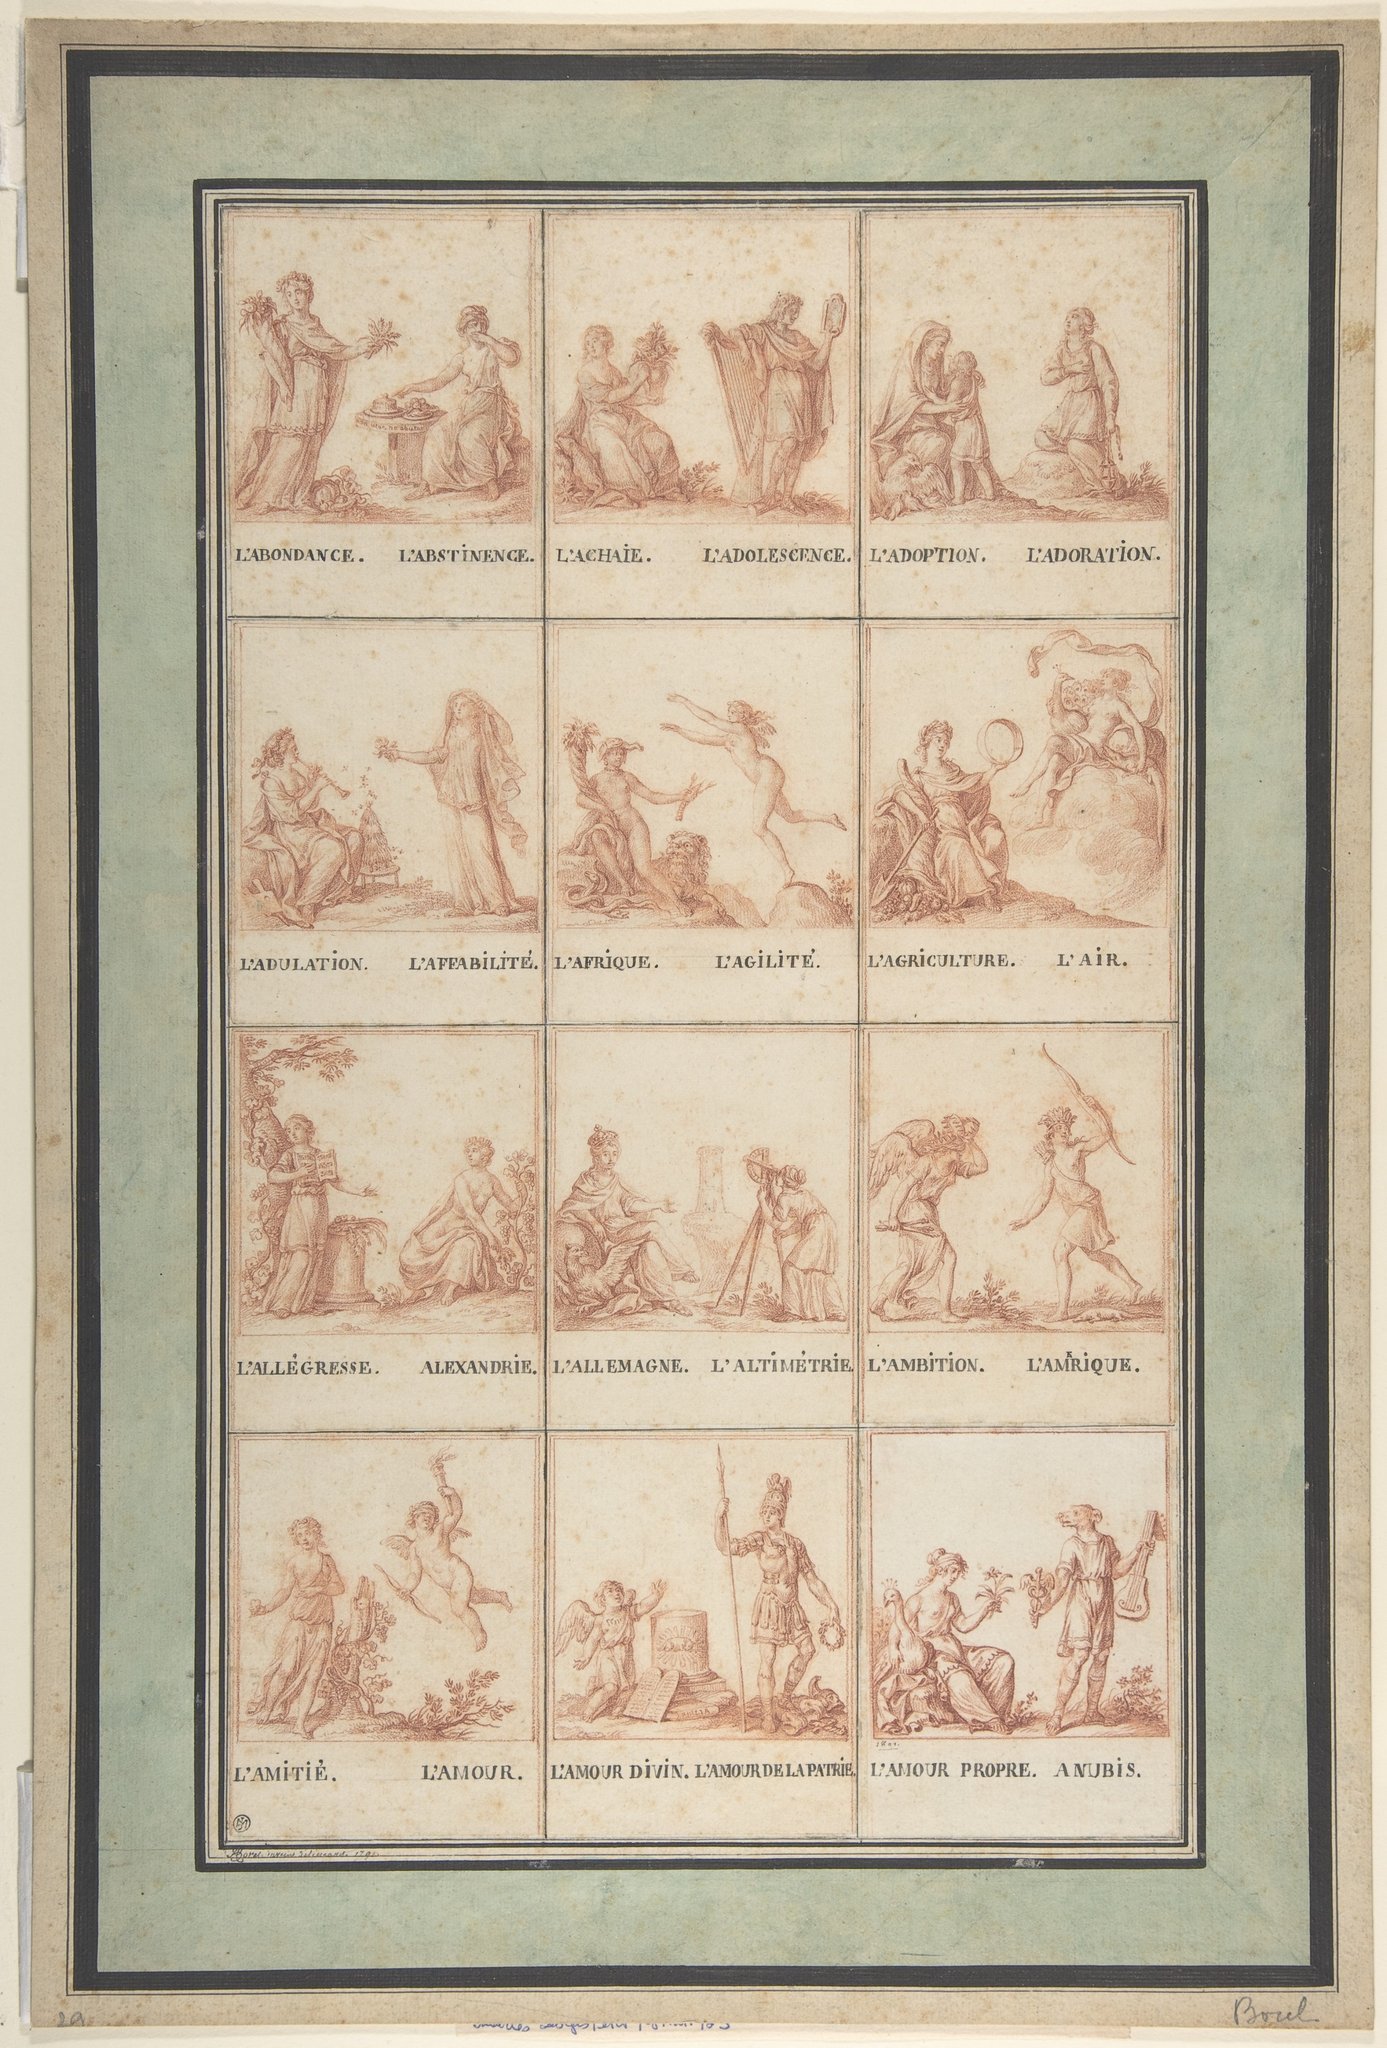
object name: drawing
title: Illustrations for an Allegorical Pattern Book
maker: antoine borel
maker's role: artist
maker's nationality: french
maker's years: 1743-1843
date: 1767-1833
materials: chalk, ink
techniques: pen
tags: human figures